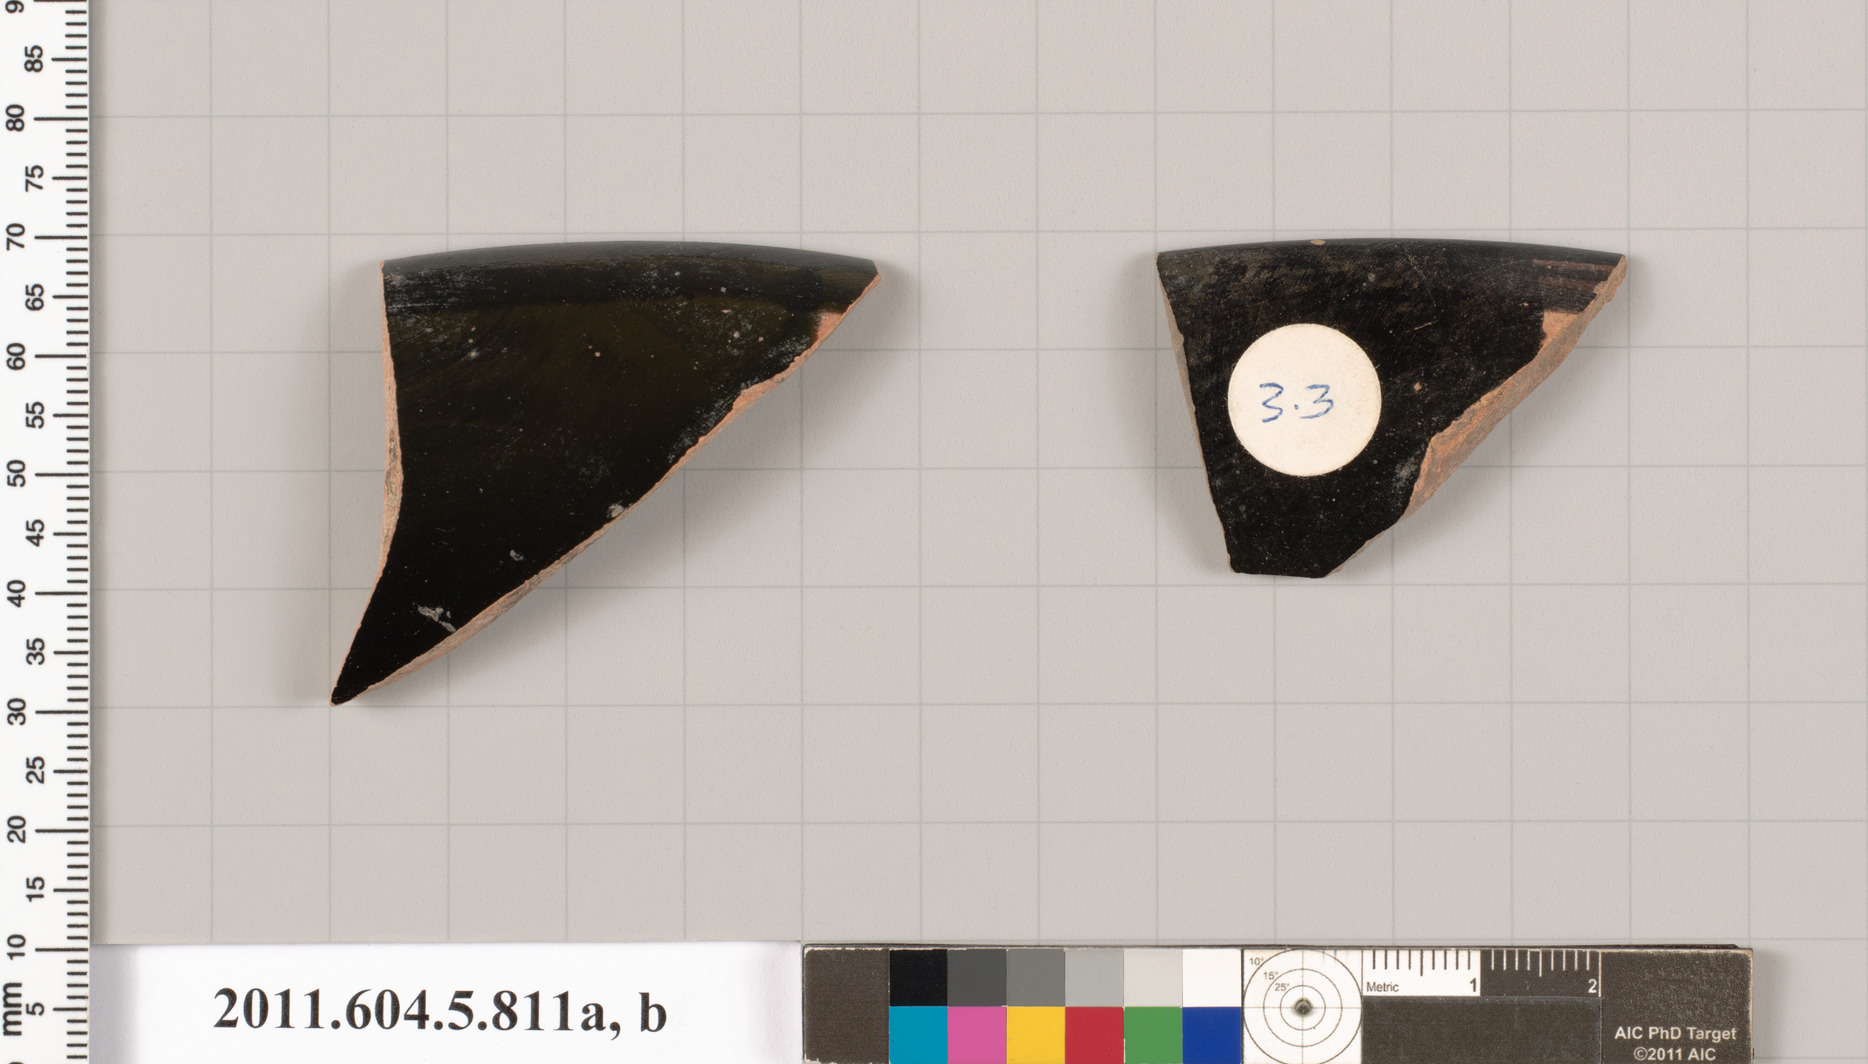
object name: kylix fragment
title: Terracotta rim fragments of kylikes (drinking cups)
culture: greek, attic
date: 600-401 BCE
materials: terracotta